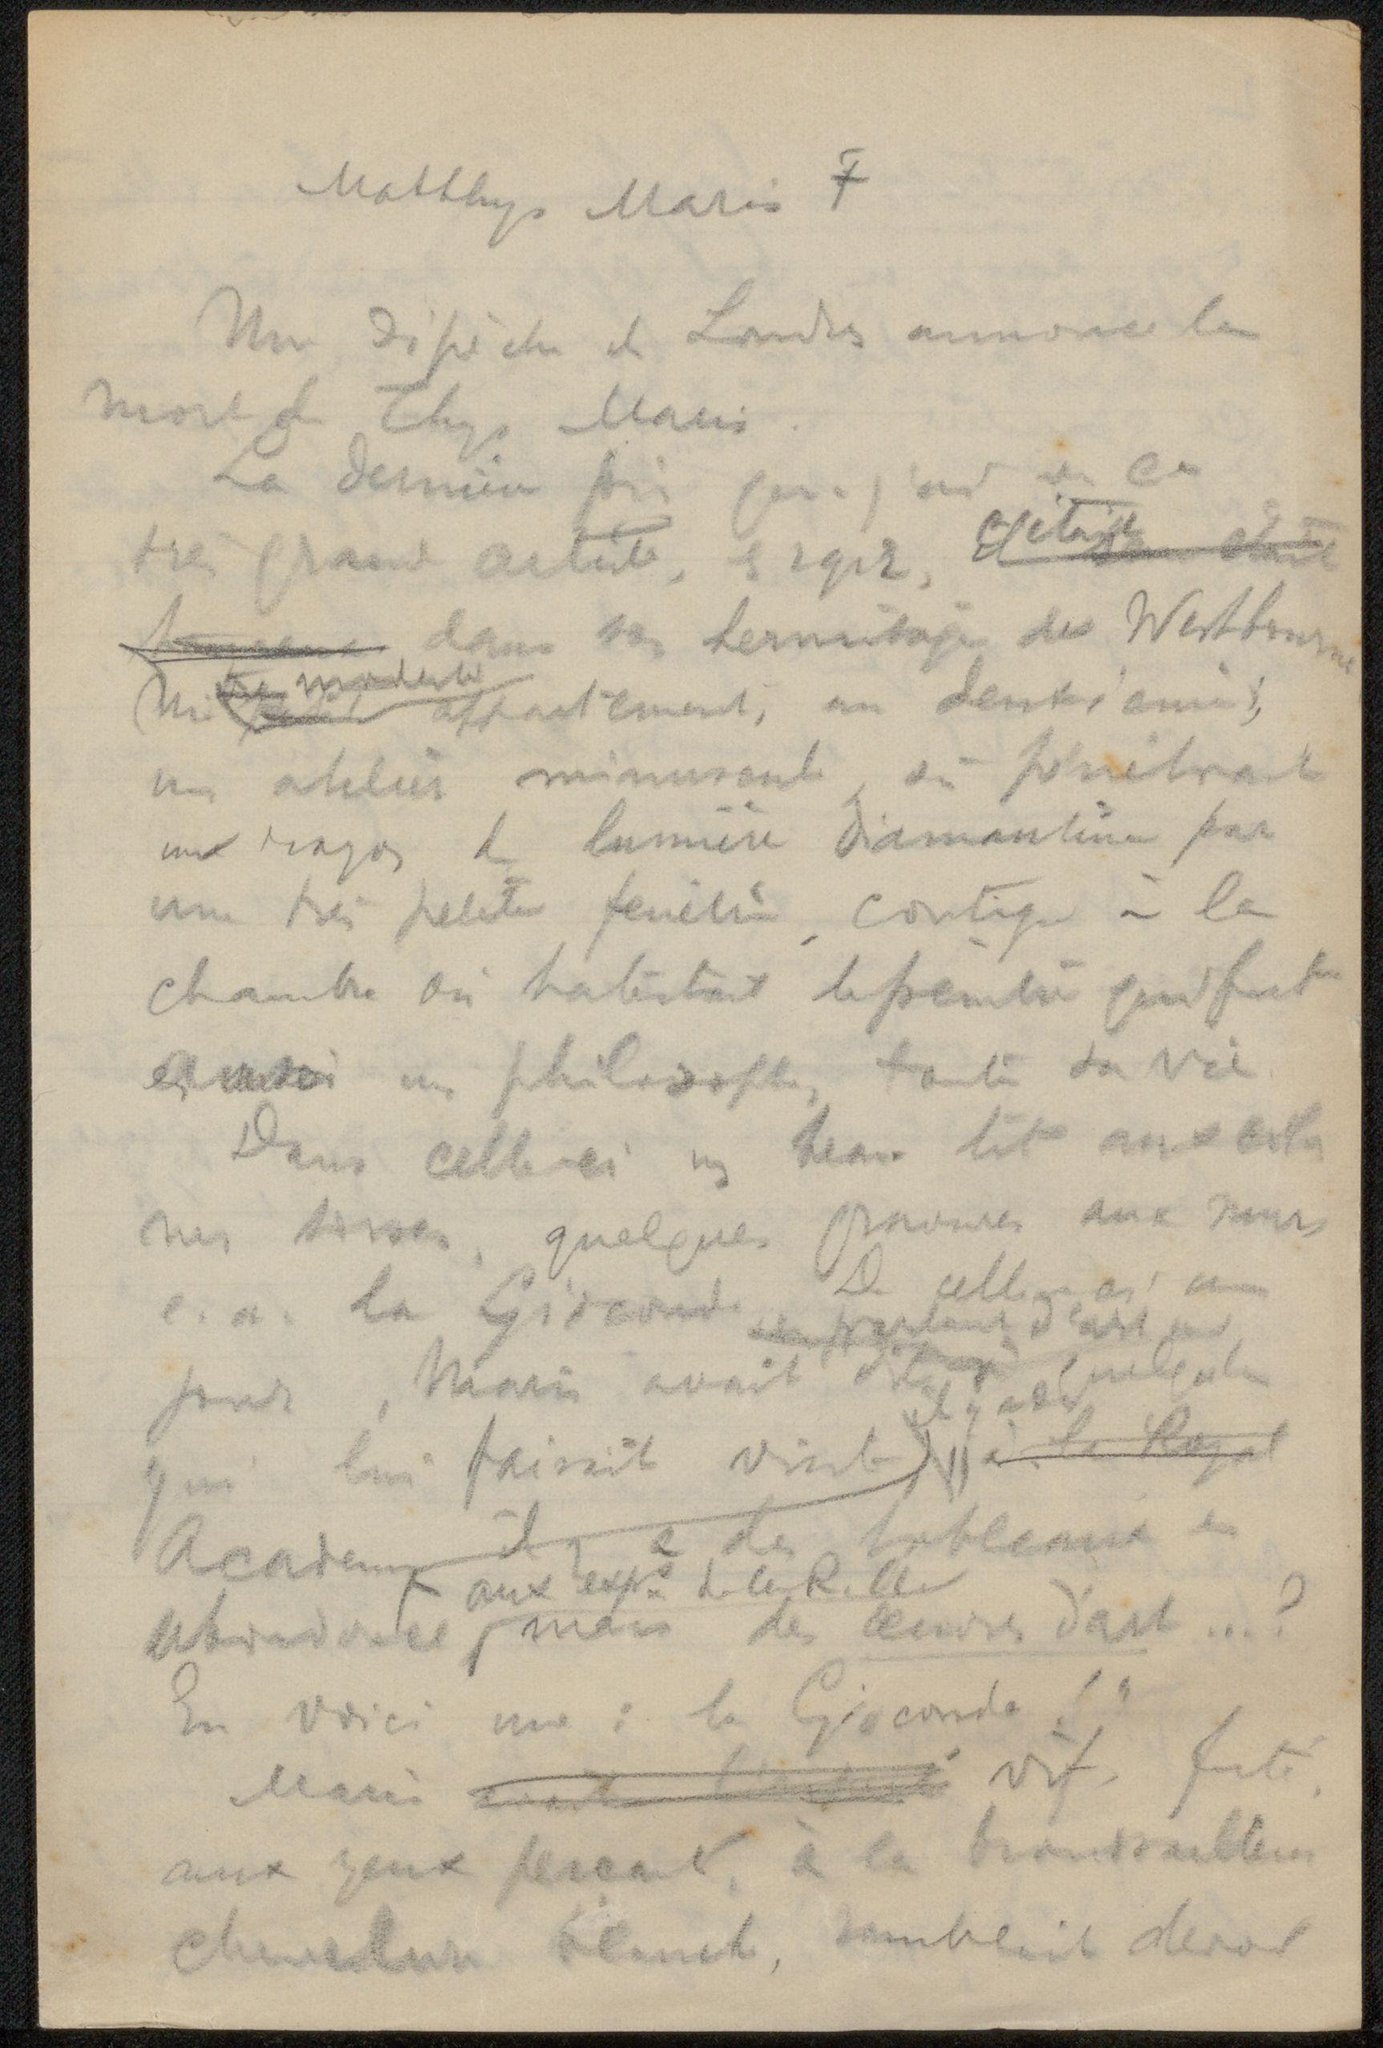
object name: manuscript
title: Manuscript uit archief Philip Zilcken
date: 1867-1930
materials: ink, paper, pencil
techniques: pen, printing, writing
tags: print maker, matthijs maris, draughtsman, philip zilcken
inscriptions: watermark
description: Handgeschreven manuscript bevat gedrukte tekst over Matthijs Maris. Deze tekst bevat een notitie aan Philip Zilcken.